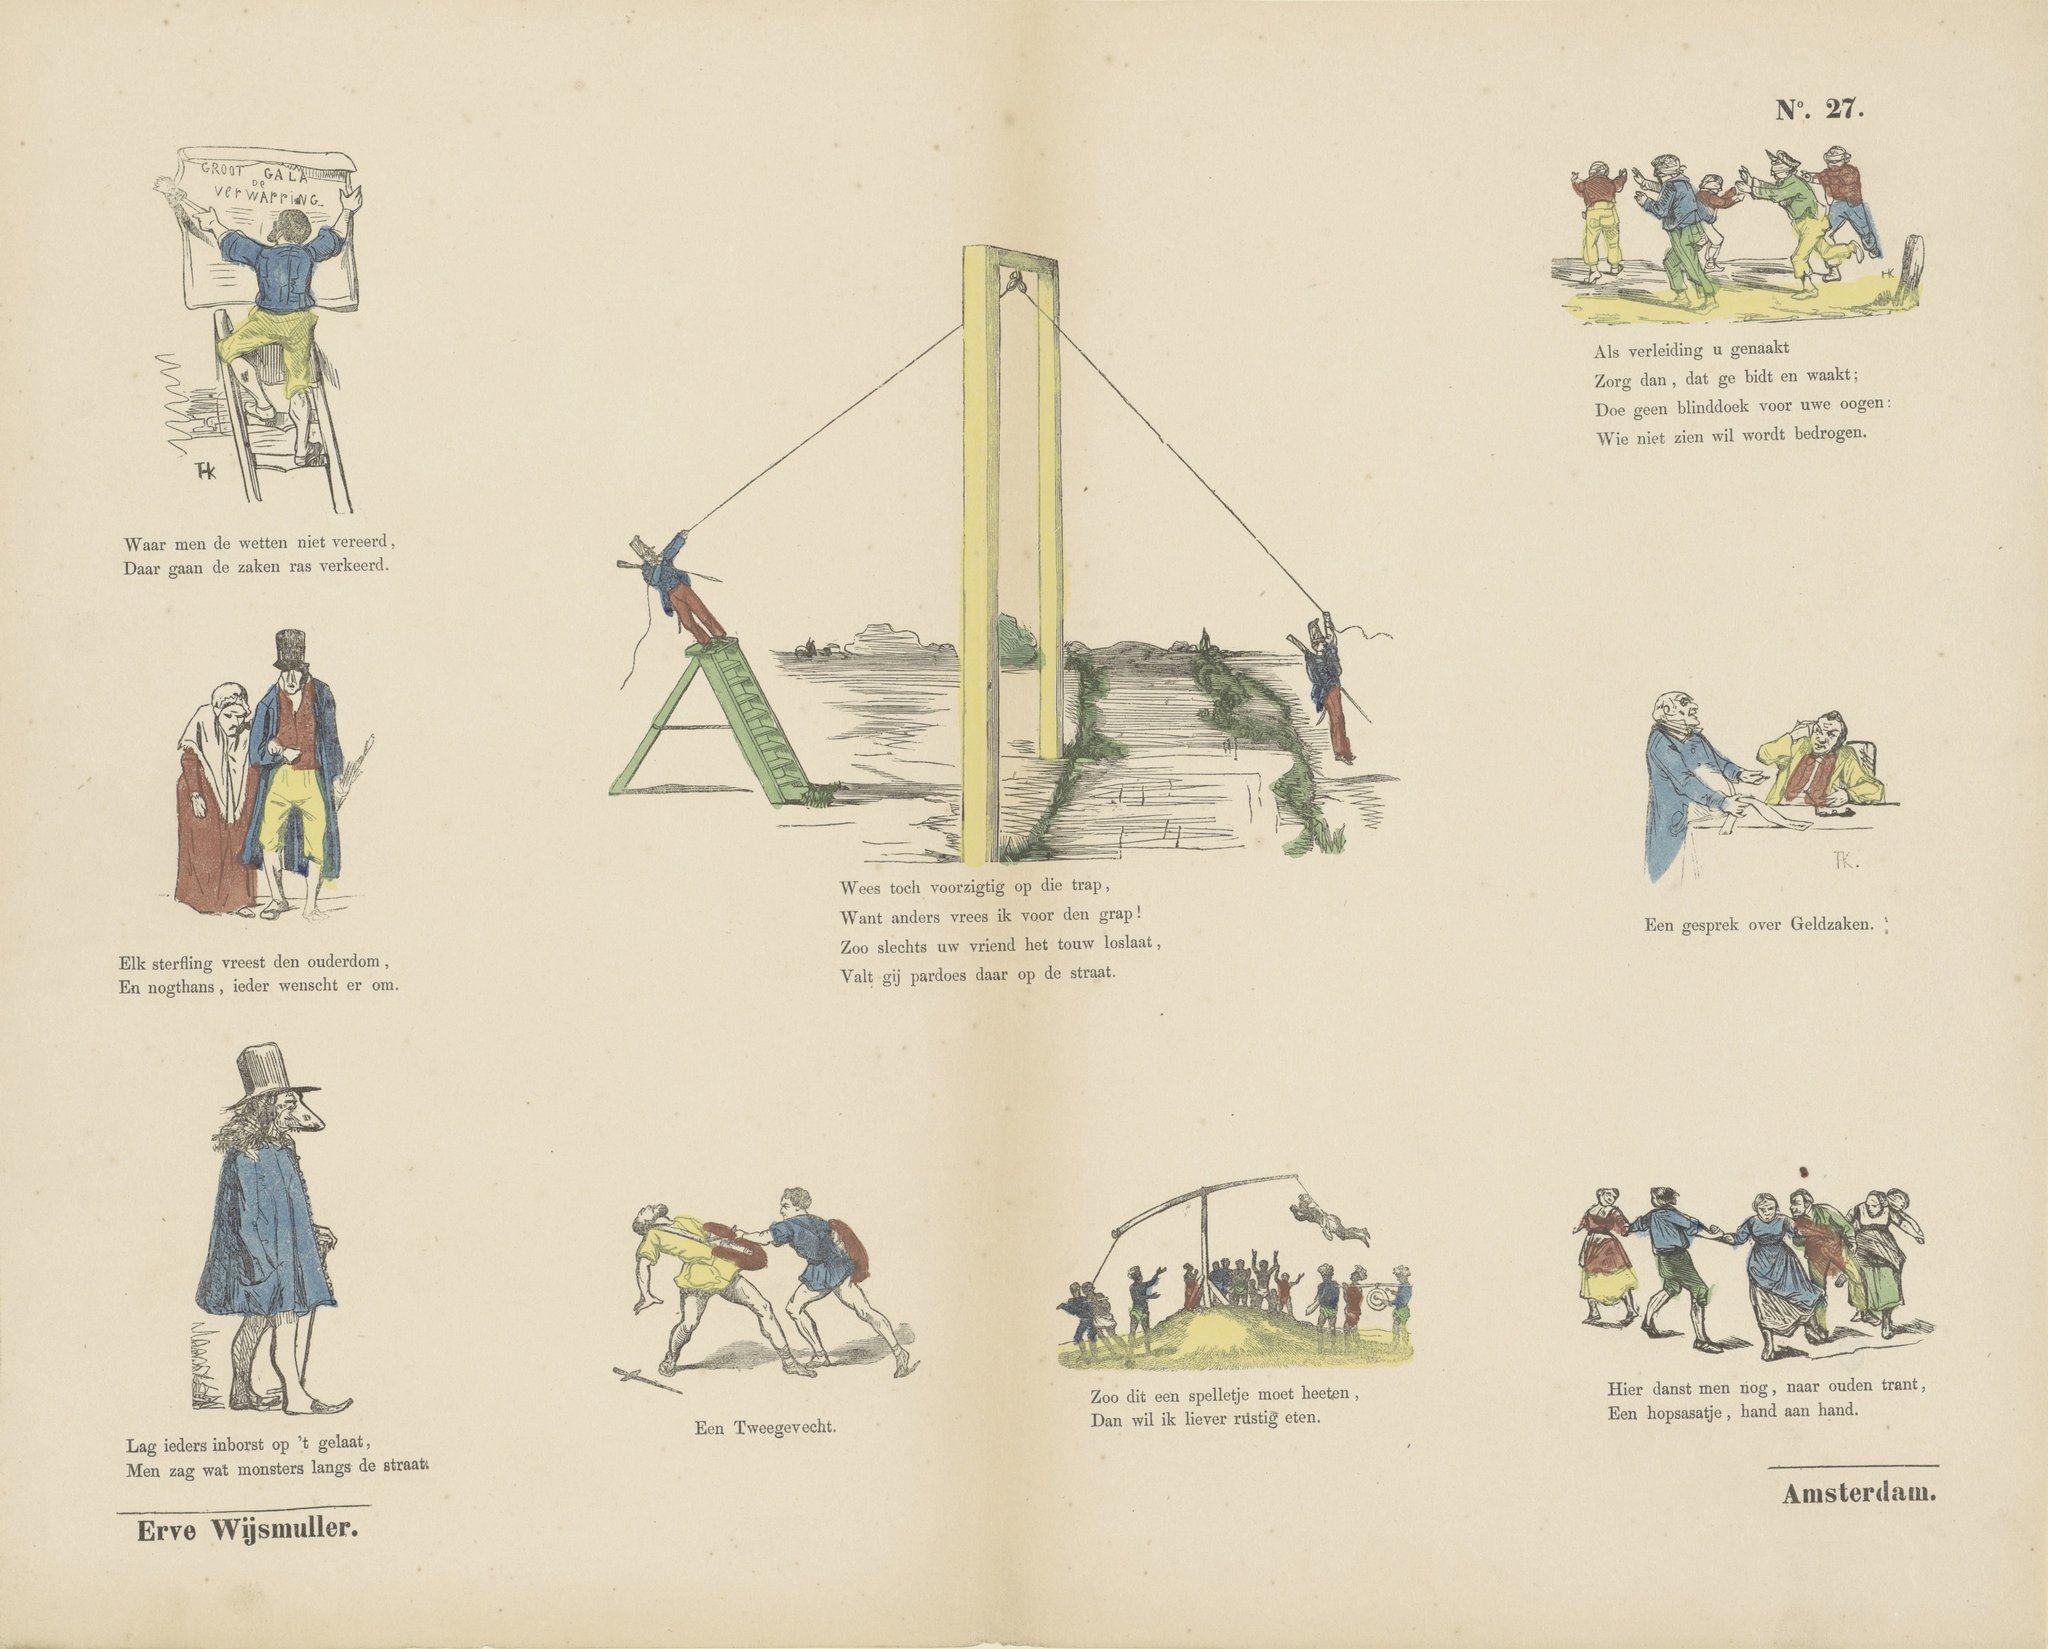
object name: popular print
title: Verschillende voorstellingen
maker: Anonymous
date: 1828-1913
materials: paper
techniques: colour, letterpress printing, line block, engraving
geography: netherlands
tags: characters (human types), group dancing, fighting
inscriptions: collector's mark: Lugt 2760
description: Blad met 9 voorstellingen van verschillende aard, waaronder een ouder paar, een tweegevecht, dansende mensen en een gesprek over geldzaken. Onder elke afbeelding een onderschrift. Onder de eerste afbeelding het onderschrift: Waar men de wetten niet vereerd, / Daar gaan de zaken ras verkeerd. Genummerd rechtsboven: No. 27.